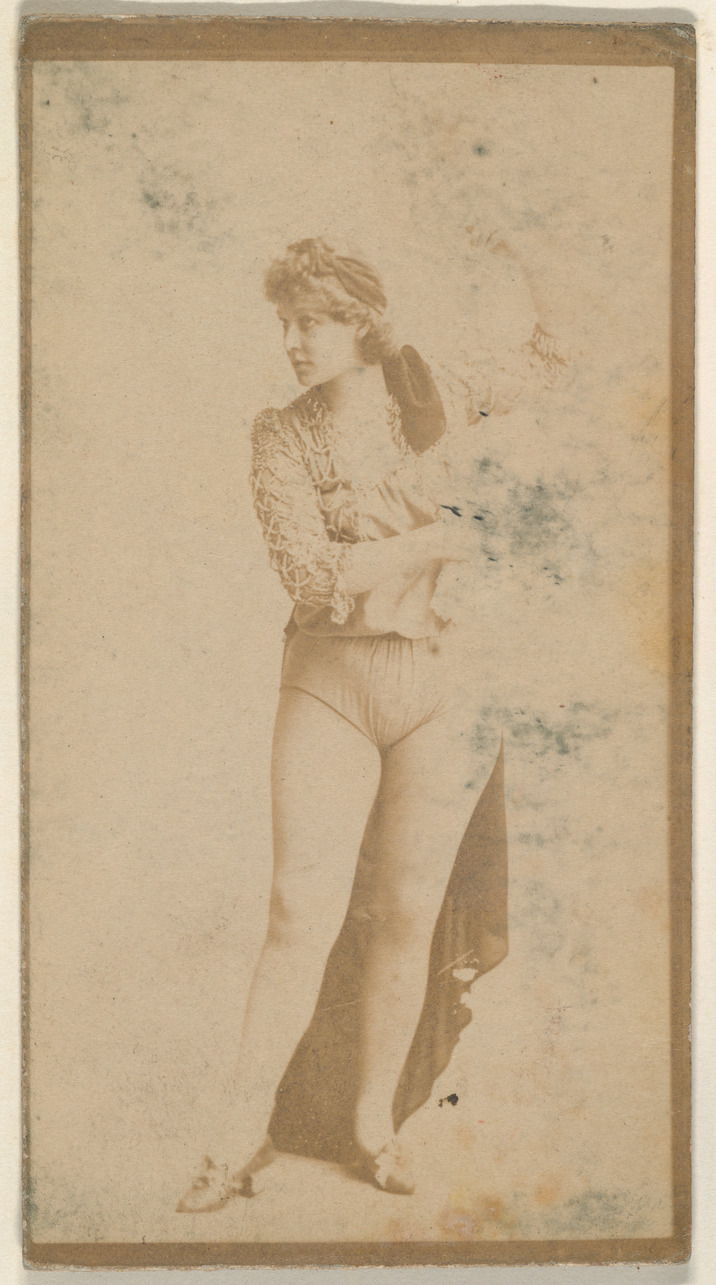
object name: photograph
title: Actress standing with foot extended, from the Actresses series (N668)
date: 1888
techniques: albumen silver print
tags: portraits,women,actresses